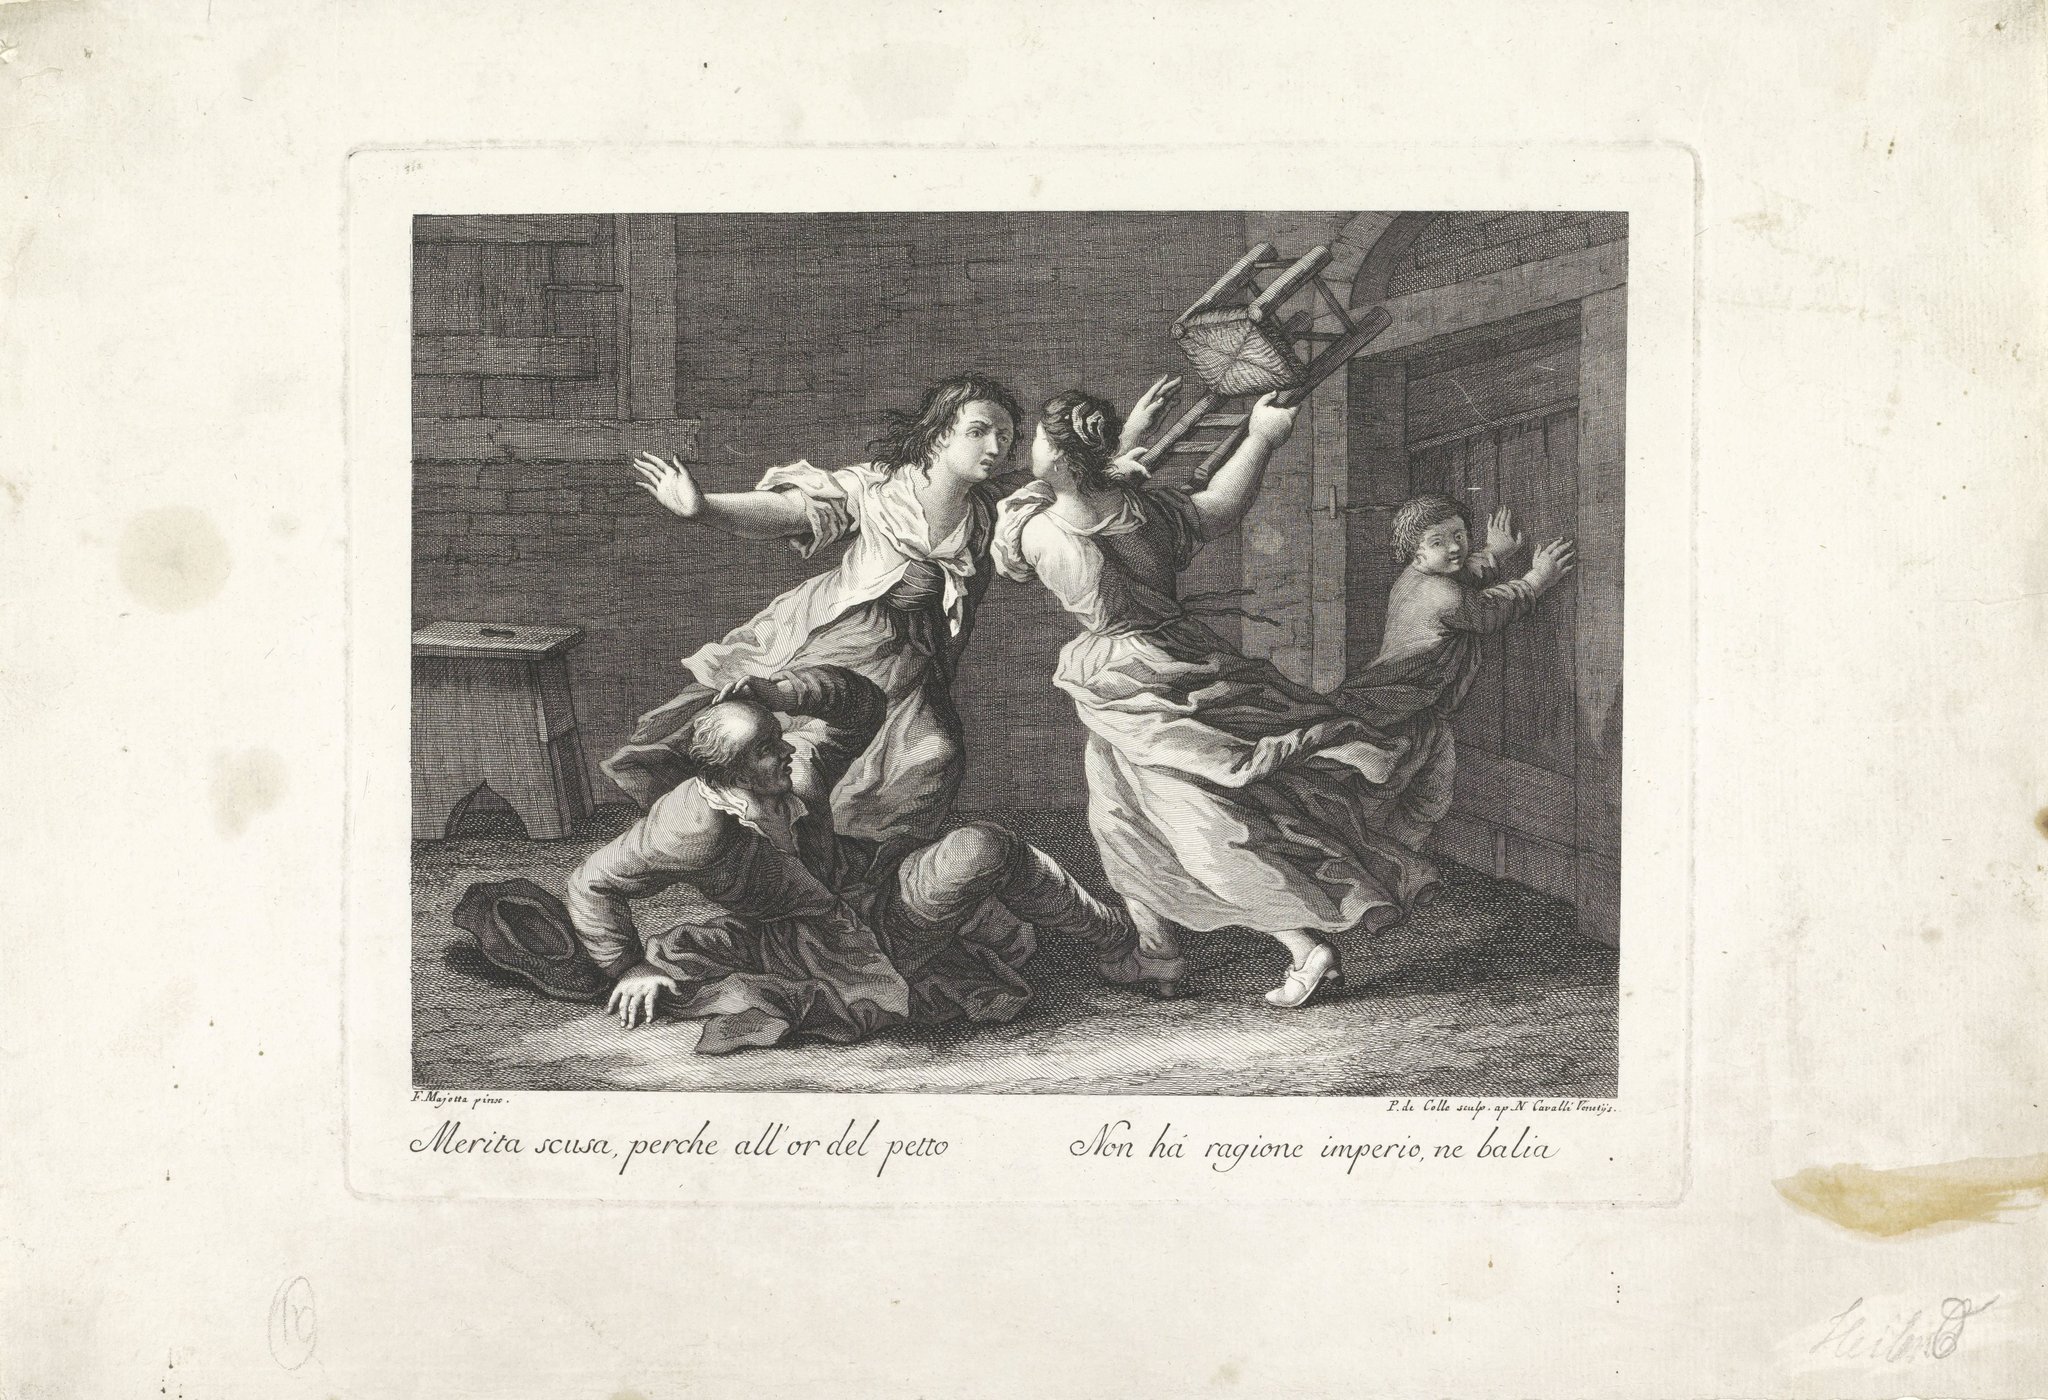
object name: print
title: Vechtende vrouwen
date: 1747-1812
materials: paper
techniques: engraving, etching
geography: italy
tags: fighting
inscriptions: collector's mark: Lugt 2228, collector's mark: Lugt 2760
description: Een vrouw probeert een man te slaan met een stoel. Een andere vrouw probeert haar tegen te houden. De man is op de grond gevallen. Op de achtergrond een jongen bij een deur.